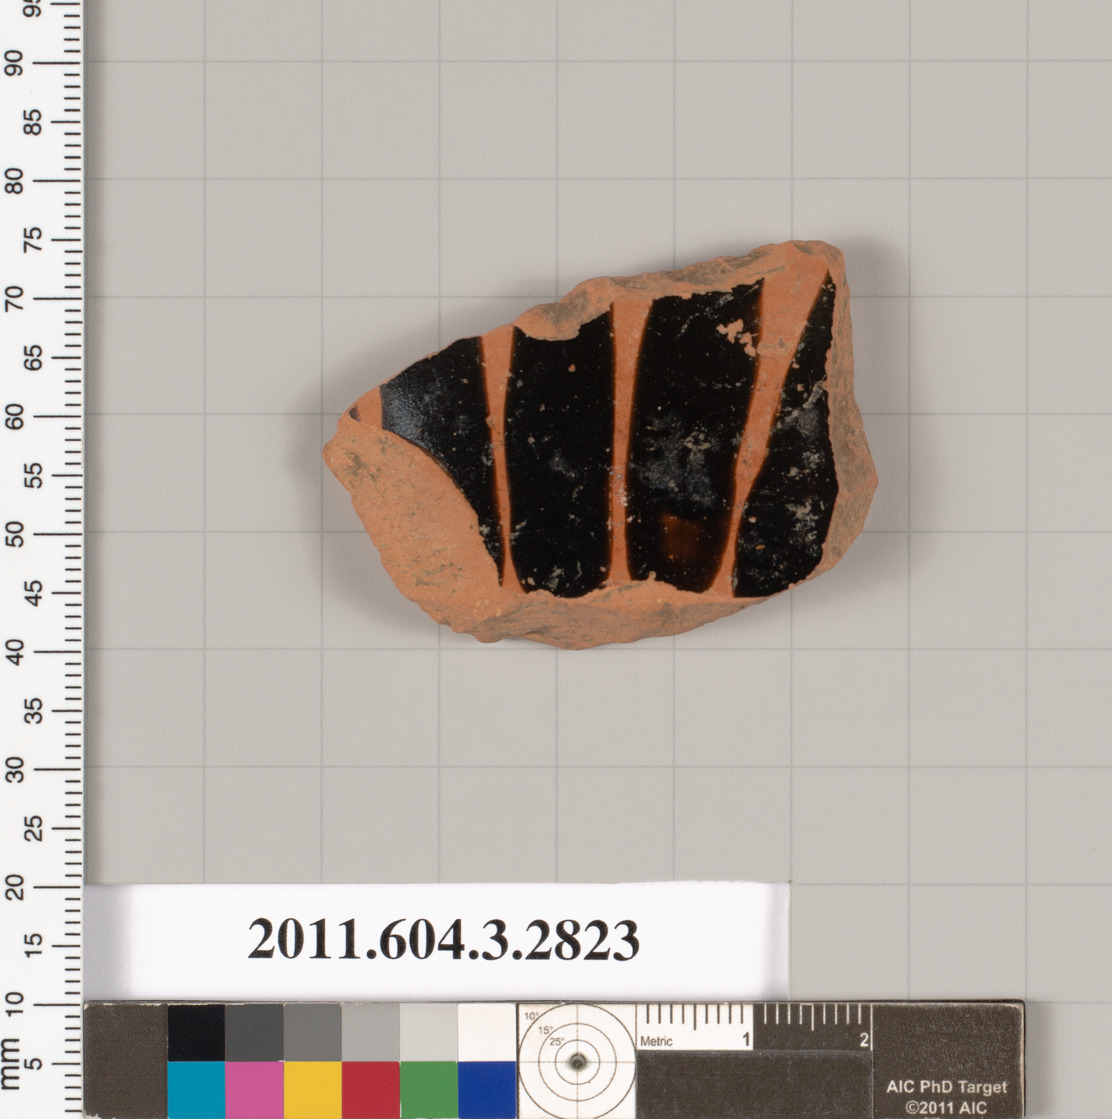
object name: amphora fragment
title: Terracotta fragment from an amphora (jar)?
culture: greek, attic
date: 600-401 BCE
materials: terracotta